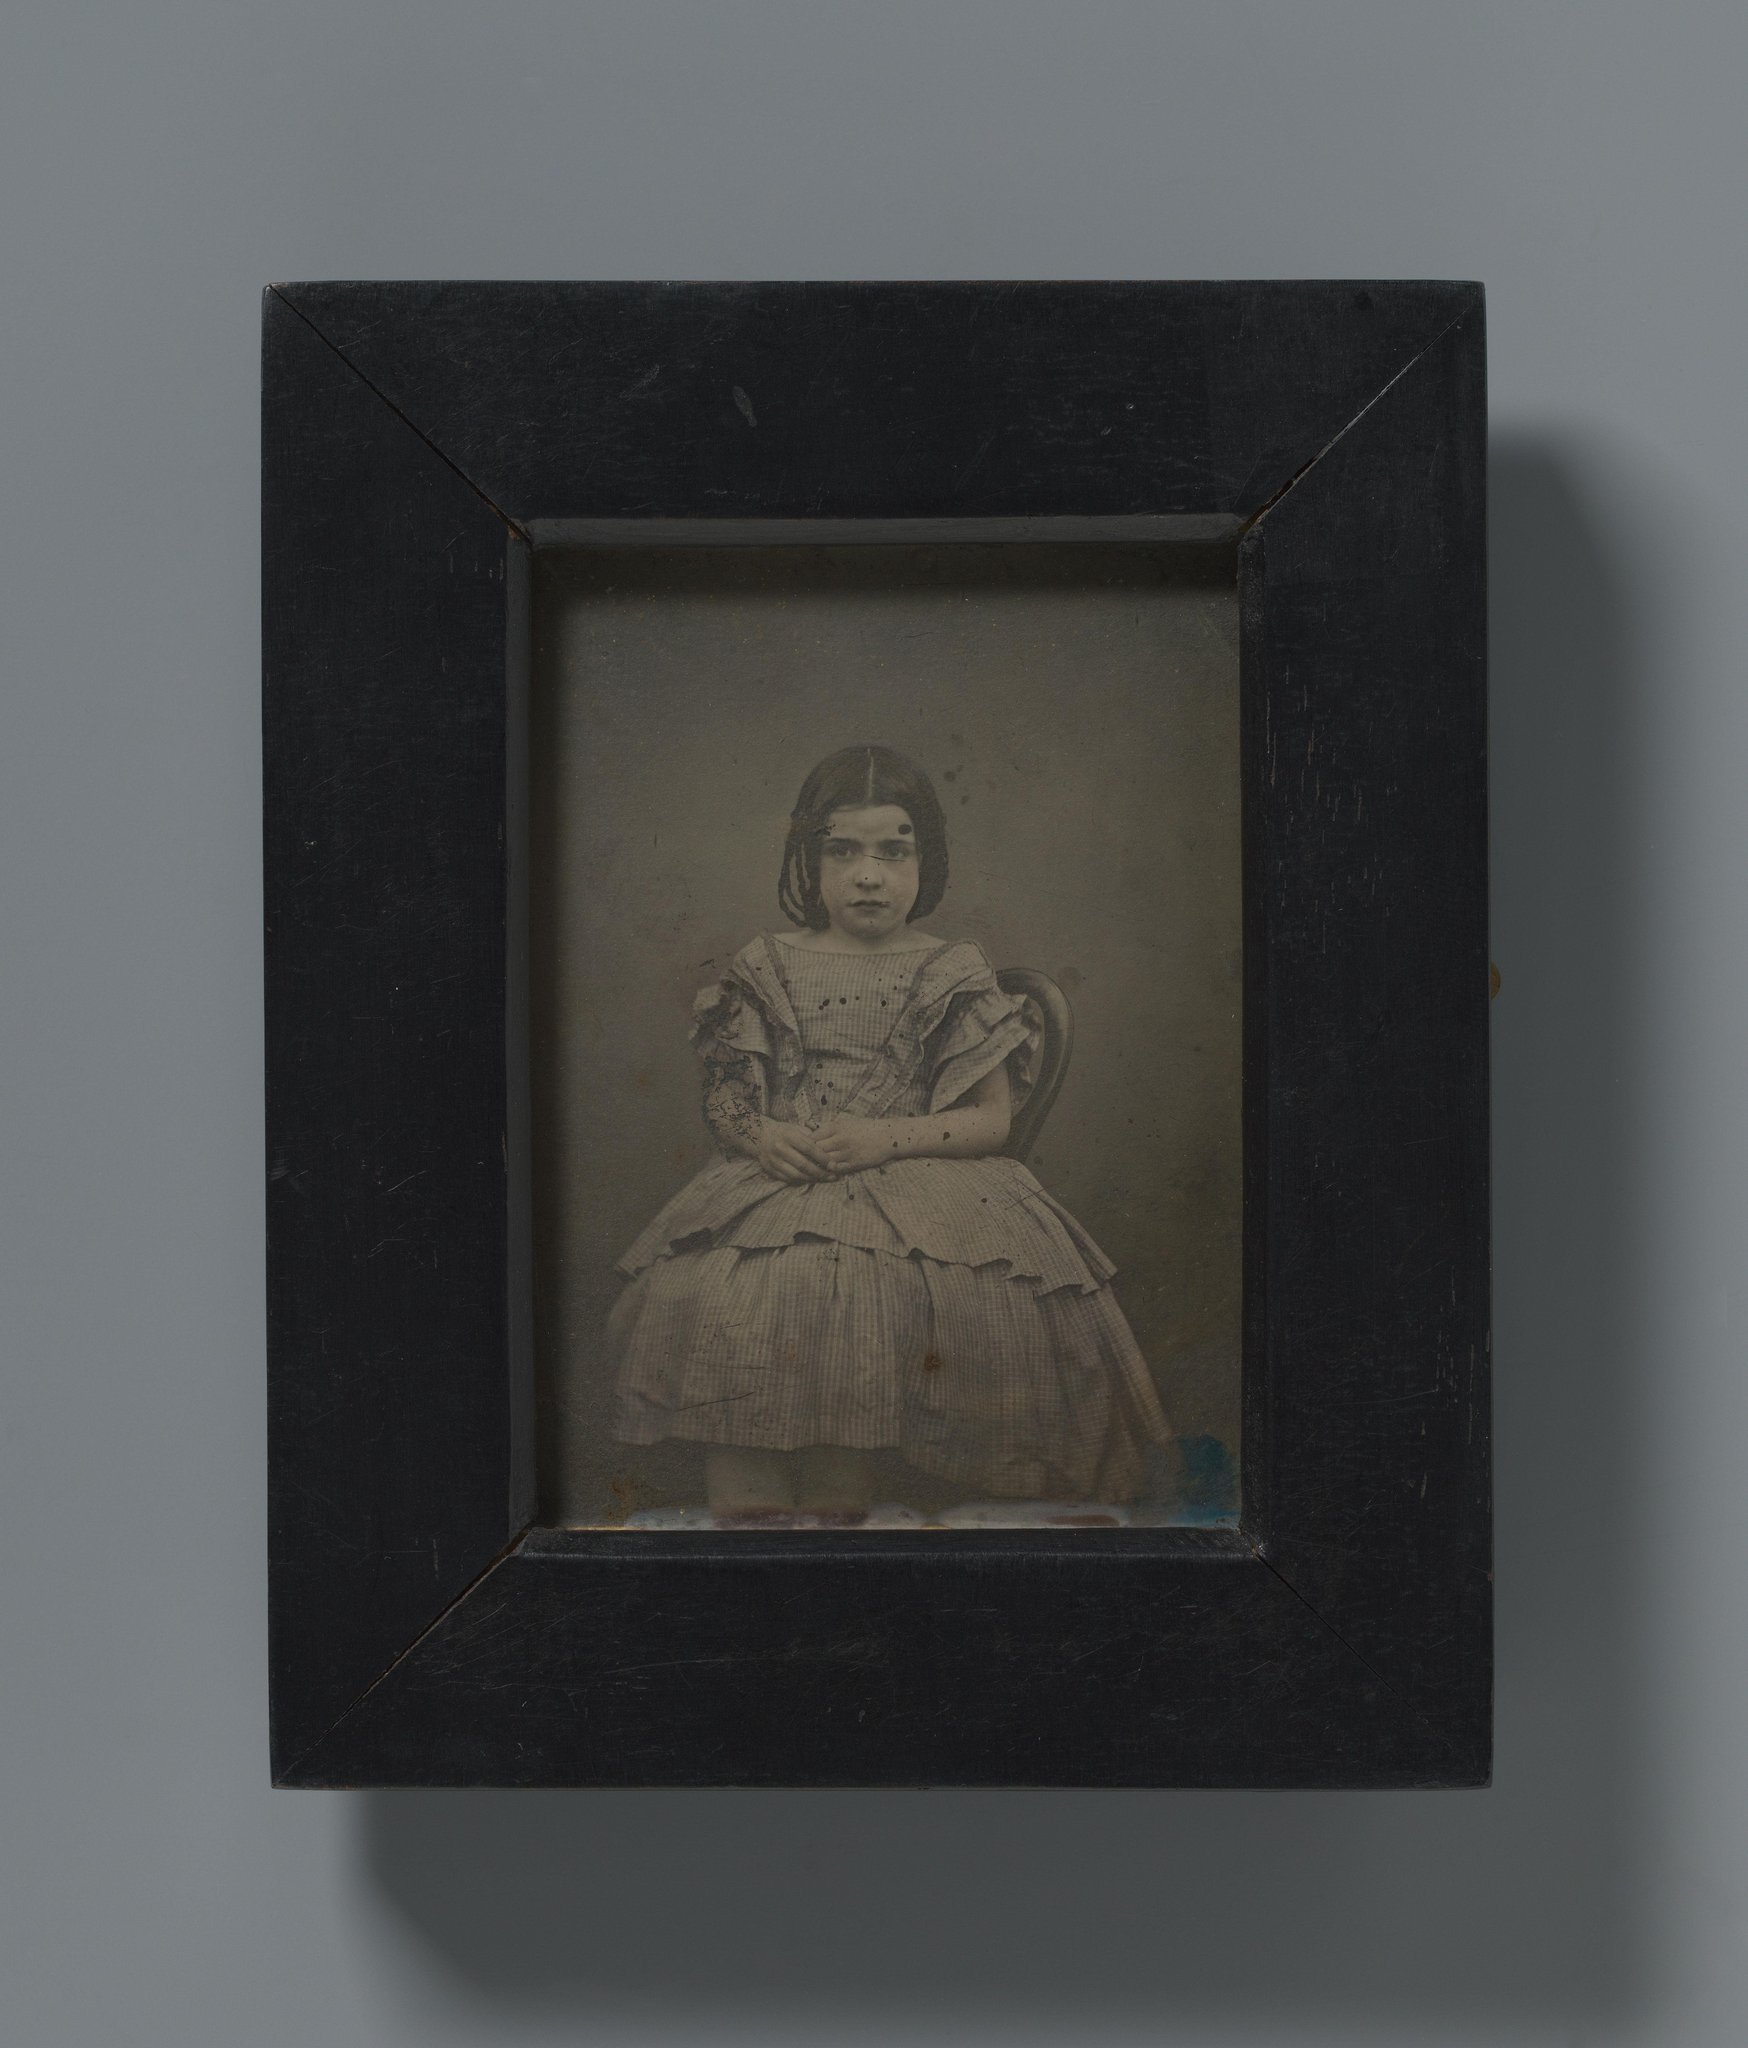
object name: photograph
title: Portret van een onbekend meisje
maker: Anonymous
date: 1855-1870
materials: glass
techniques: ambrotype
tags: historical persons - bb - woman, child